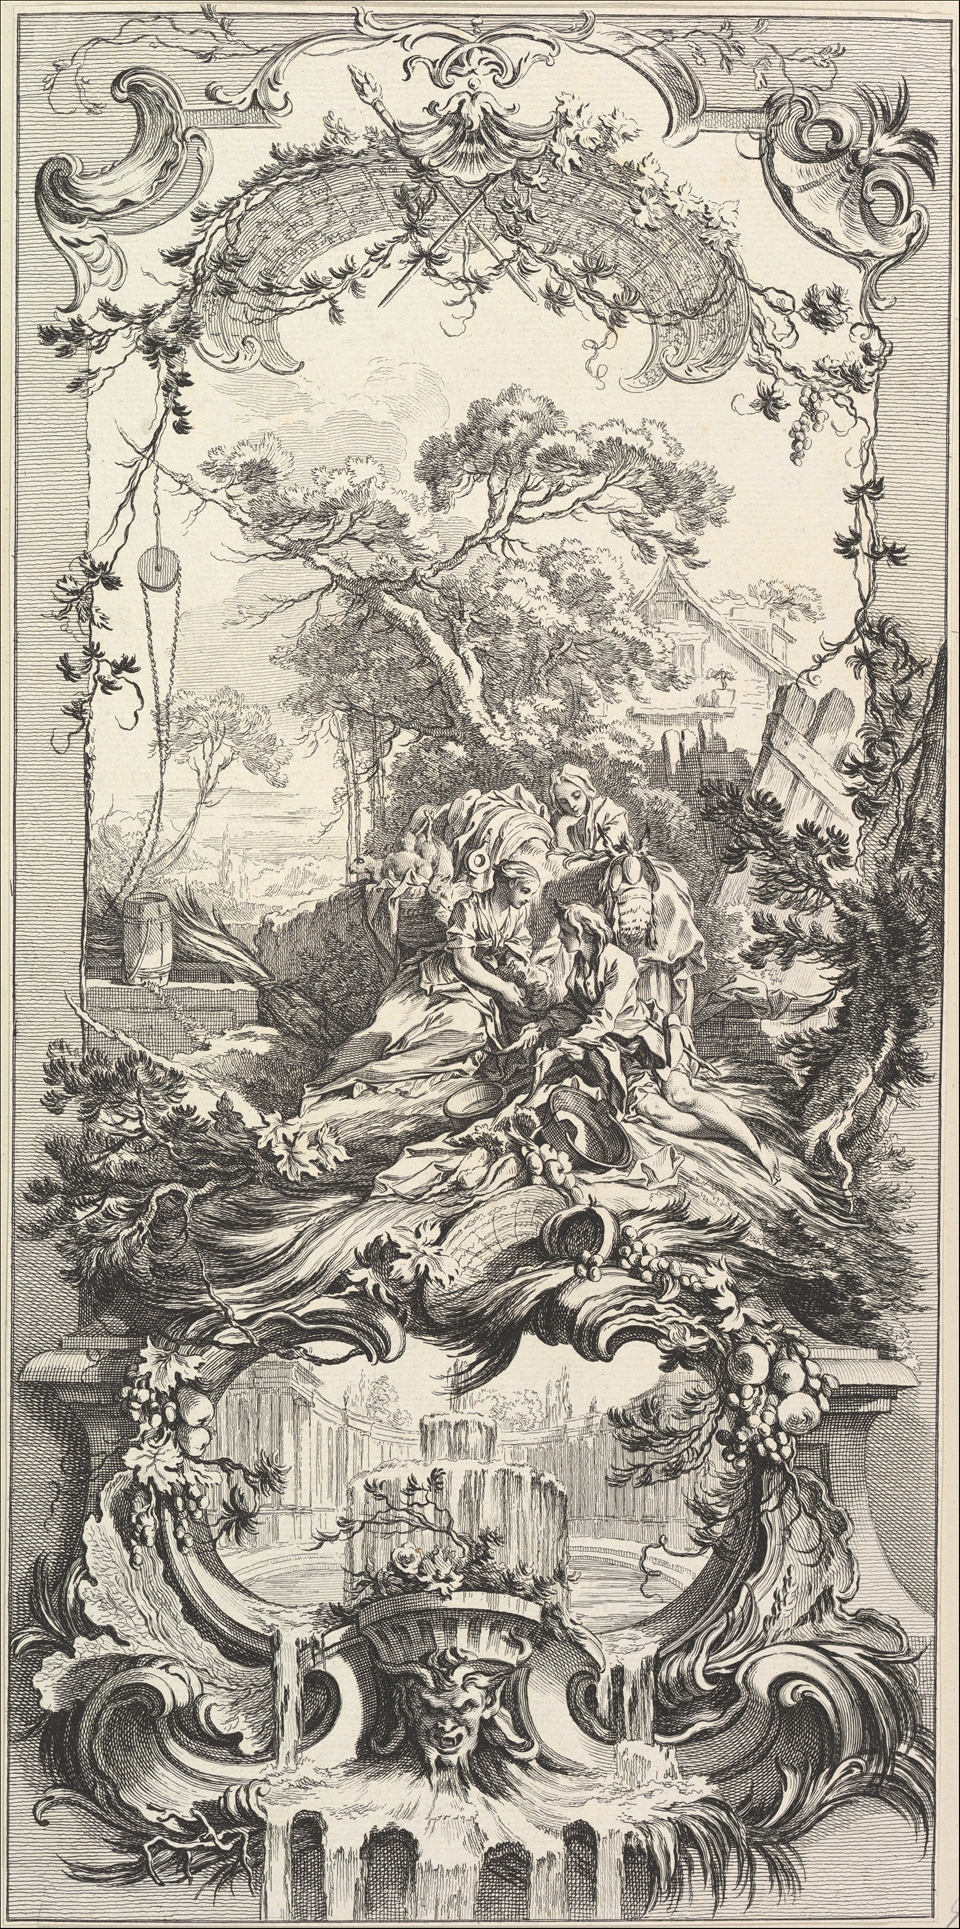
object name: collection ornament architecture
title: Triomphe de Pomone (Triumph of Pomona)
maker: charles nicolas cochin ii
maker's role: artist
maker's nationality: french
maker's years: 1715-1790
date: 1701-1800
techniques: engraving, etching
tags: men,women